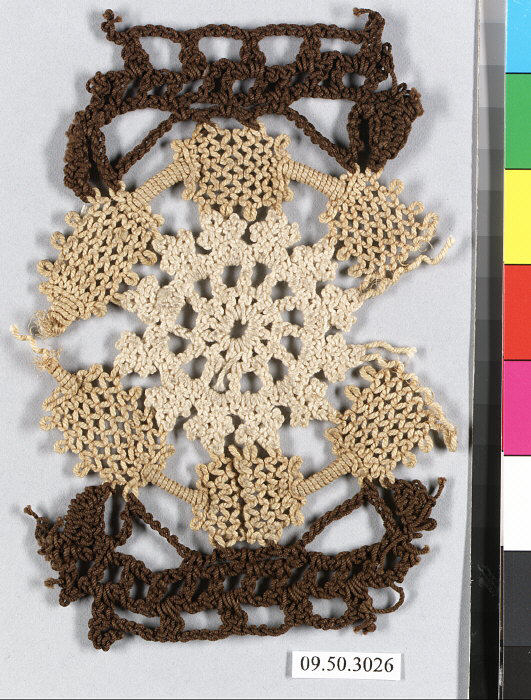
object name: sample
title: Crochet Work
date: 1801-1900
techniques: crochet